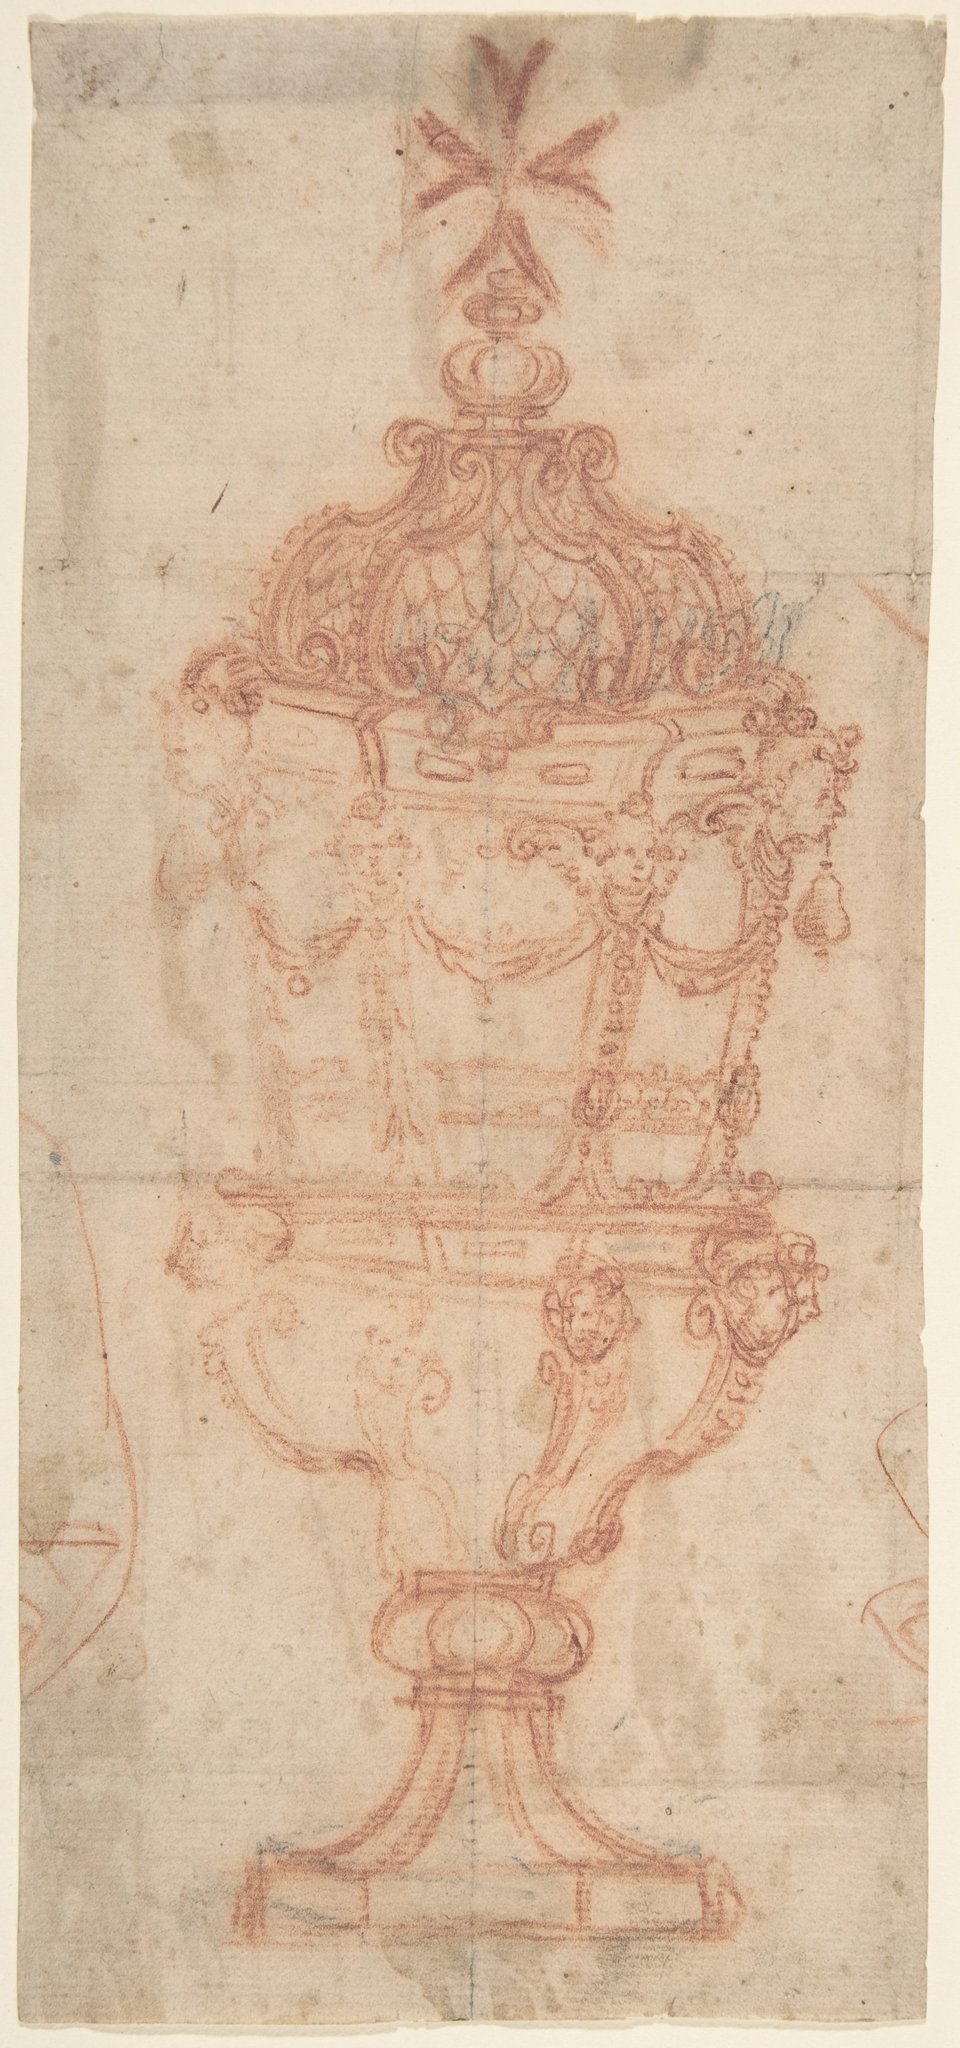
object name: drawing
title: Design for a Chalice Surmounted by a Maltese Cross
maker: anonymous, italian, florentine, second half of the 16th century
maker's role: artist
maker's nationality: italian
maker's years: 1550-1600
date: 1580-1620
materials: chalk, drawing material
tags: chalices